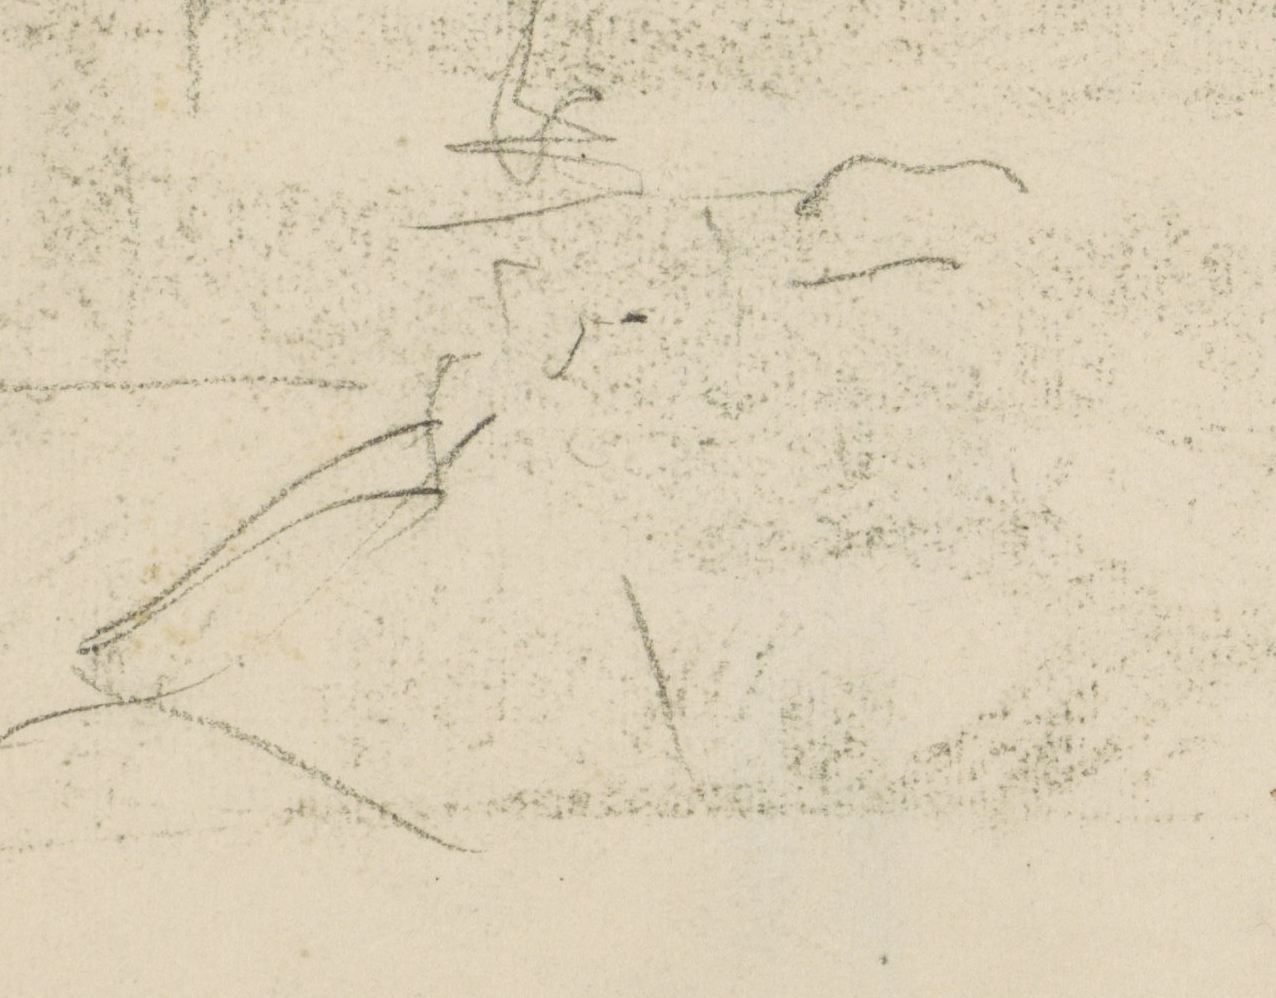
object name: sketchbook leaf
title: Studie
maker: george hendrik breitner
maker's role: draughtsman, painter, print maker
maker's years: 1857-1923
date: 1893-1899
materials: chalk, paper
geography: amsterdam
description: Pagina 51 uit een schetsboek met 28 bladen.